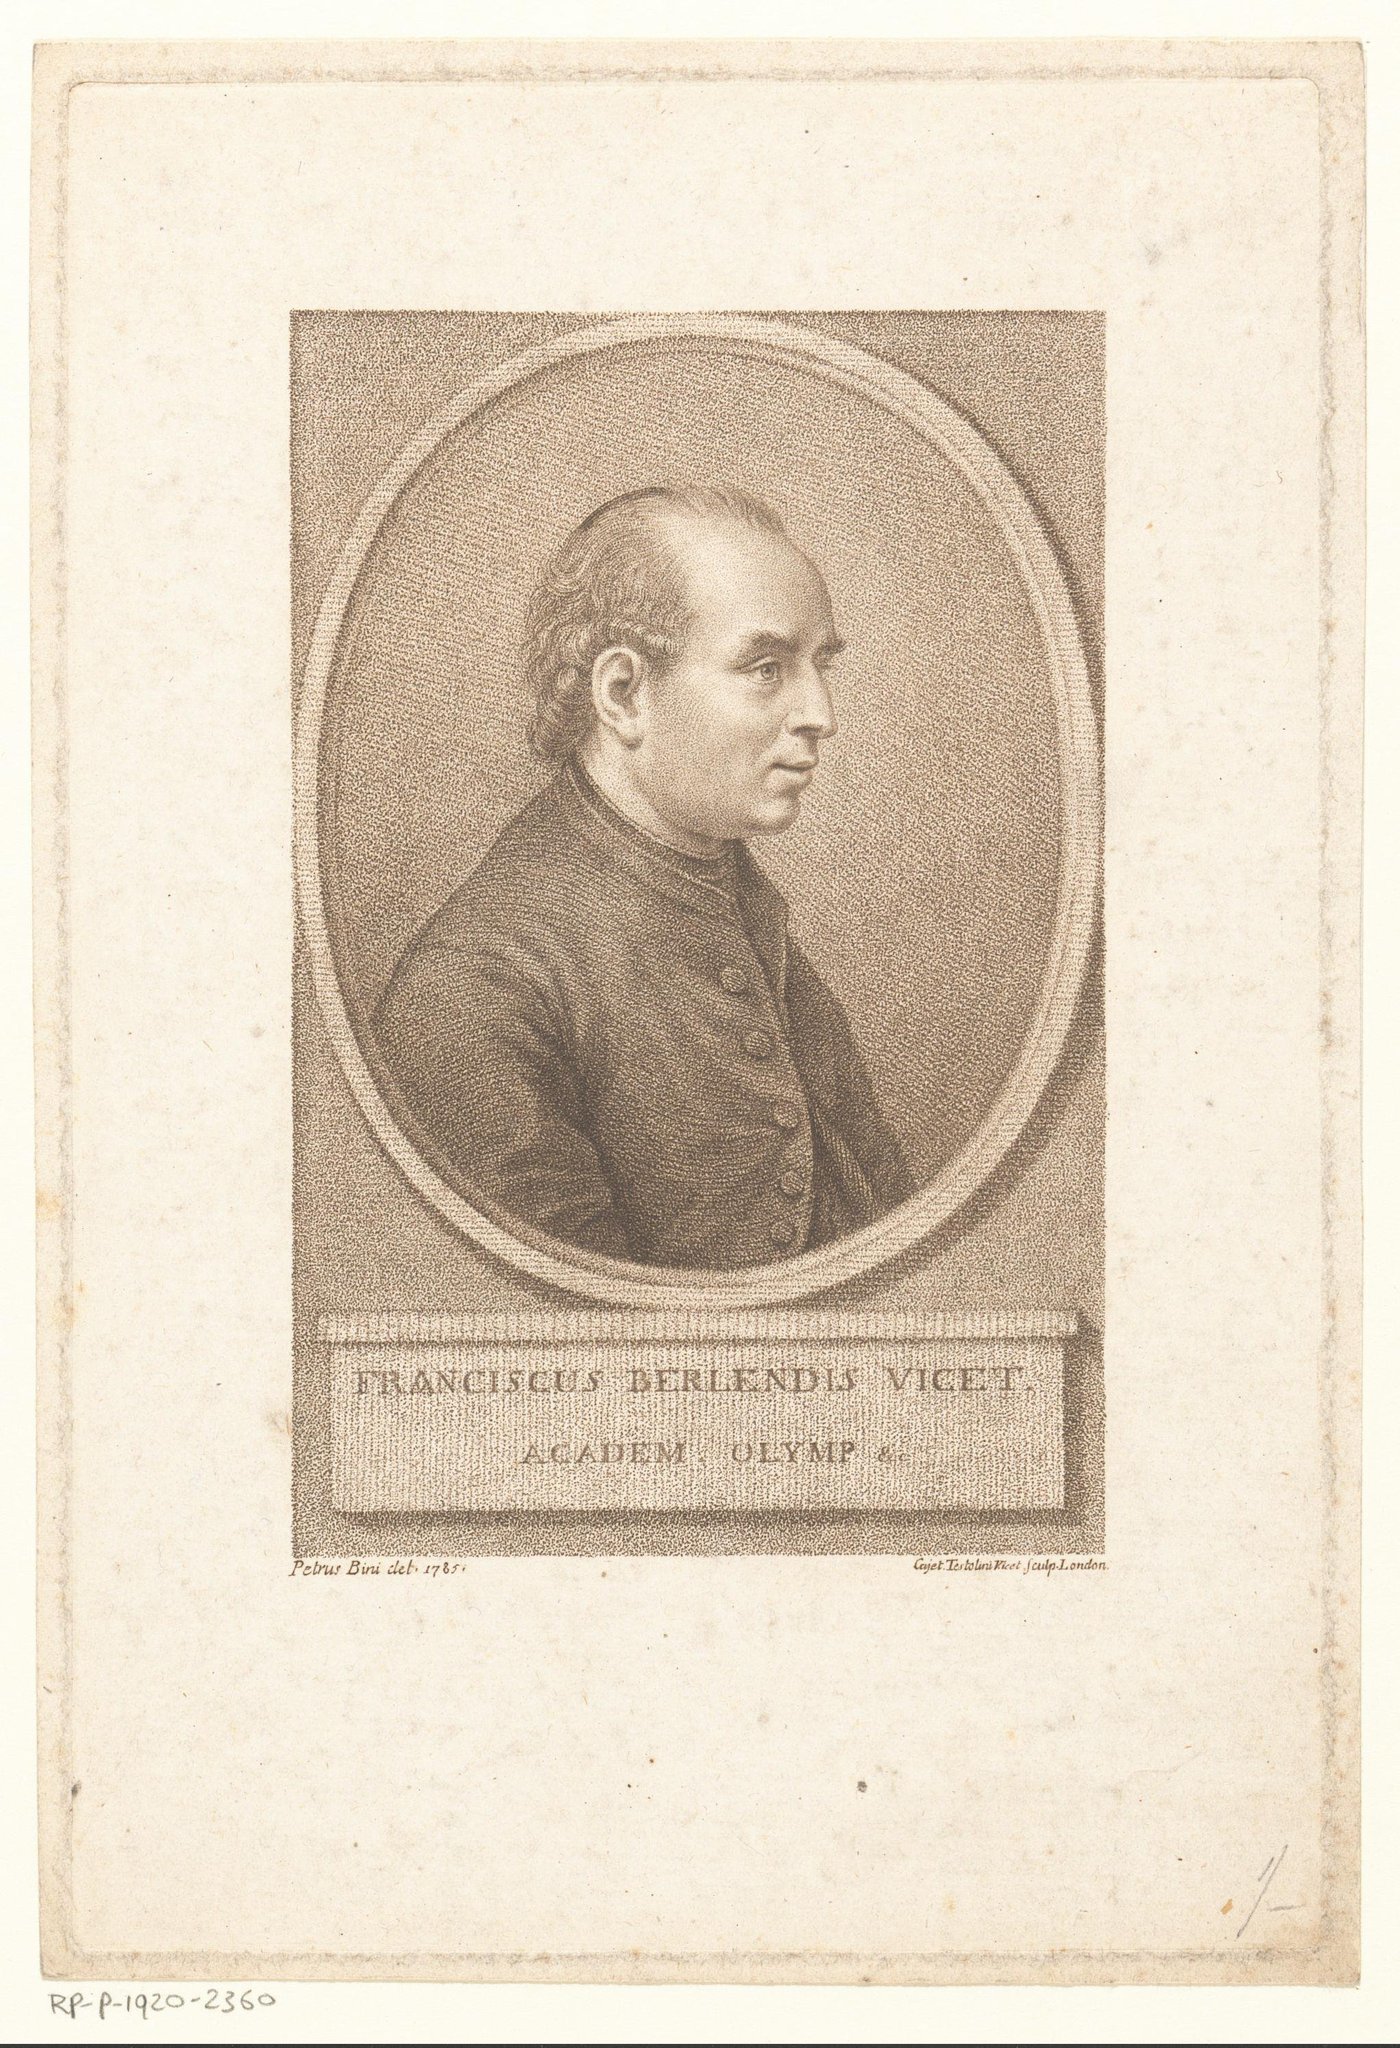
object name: print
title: Portret van Franciscus Berlendis Vicet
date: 1785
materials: paper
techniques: engraving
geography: london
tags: historical persons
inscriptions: collector's mark: Lugt 2228